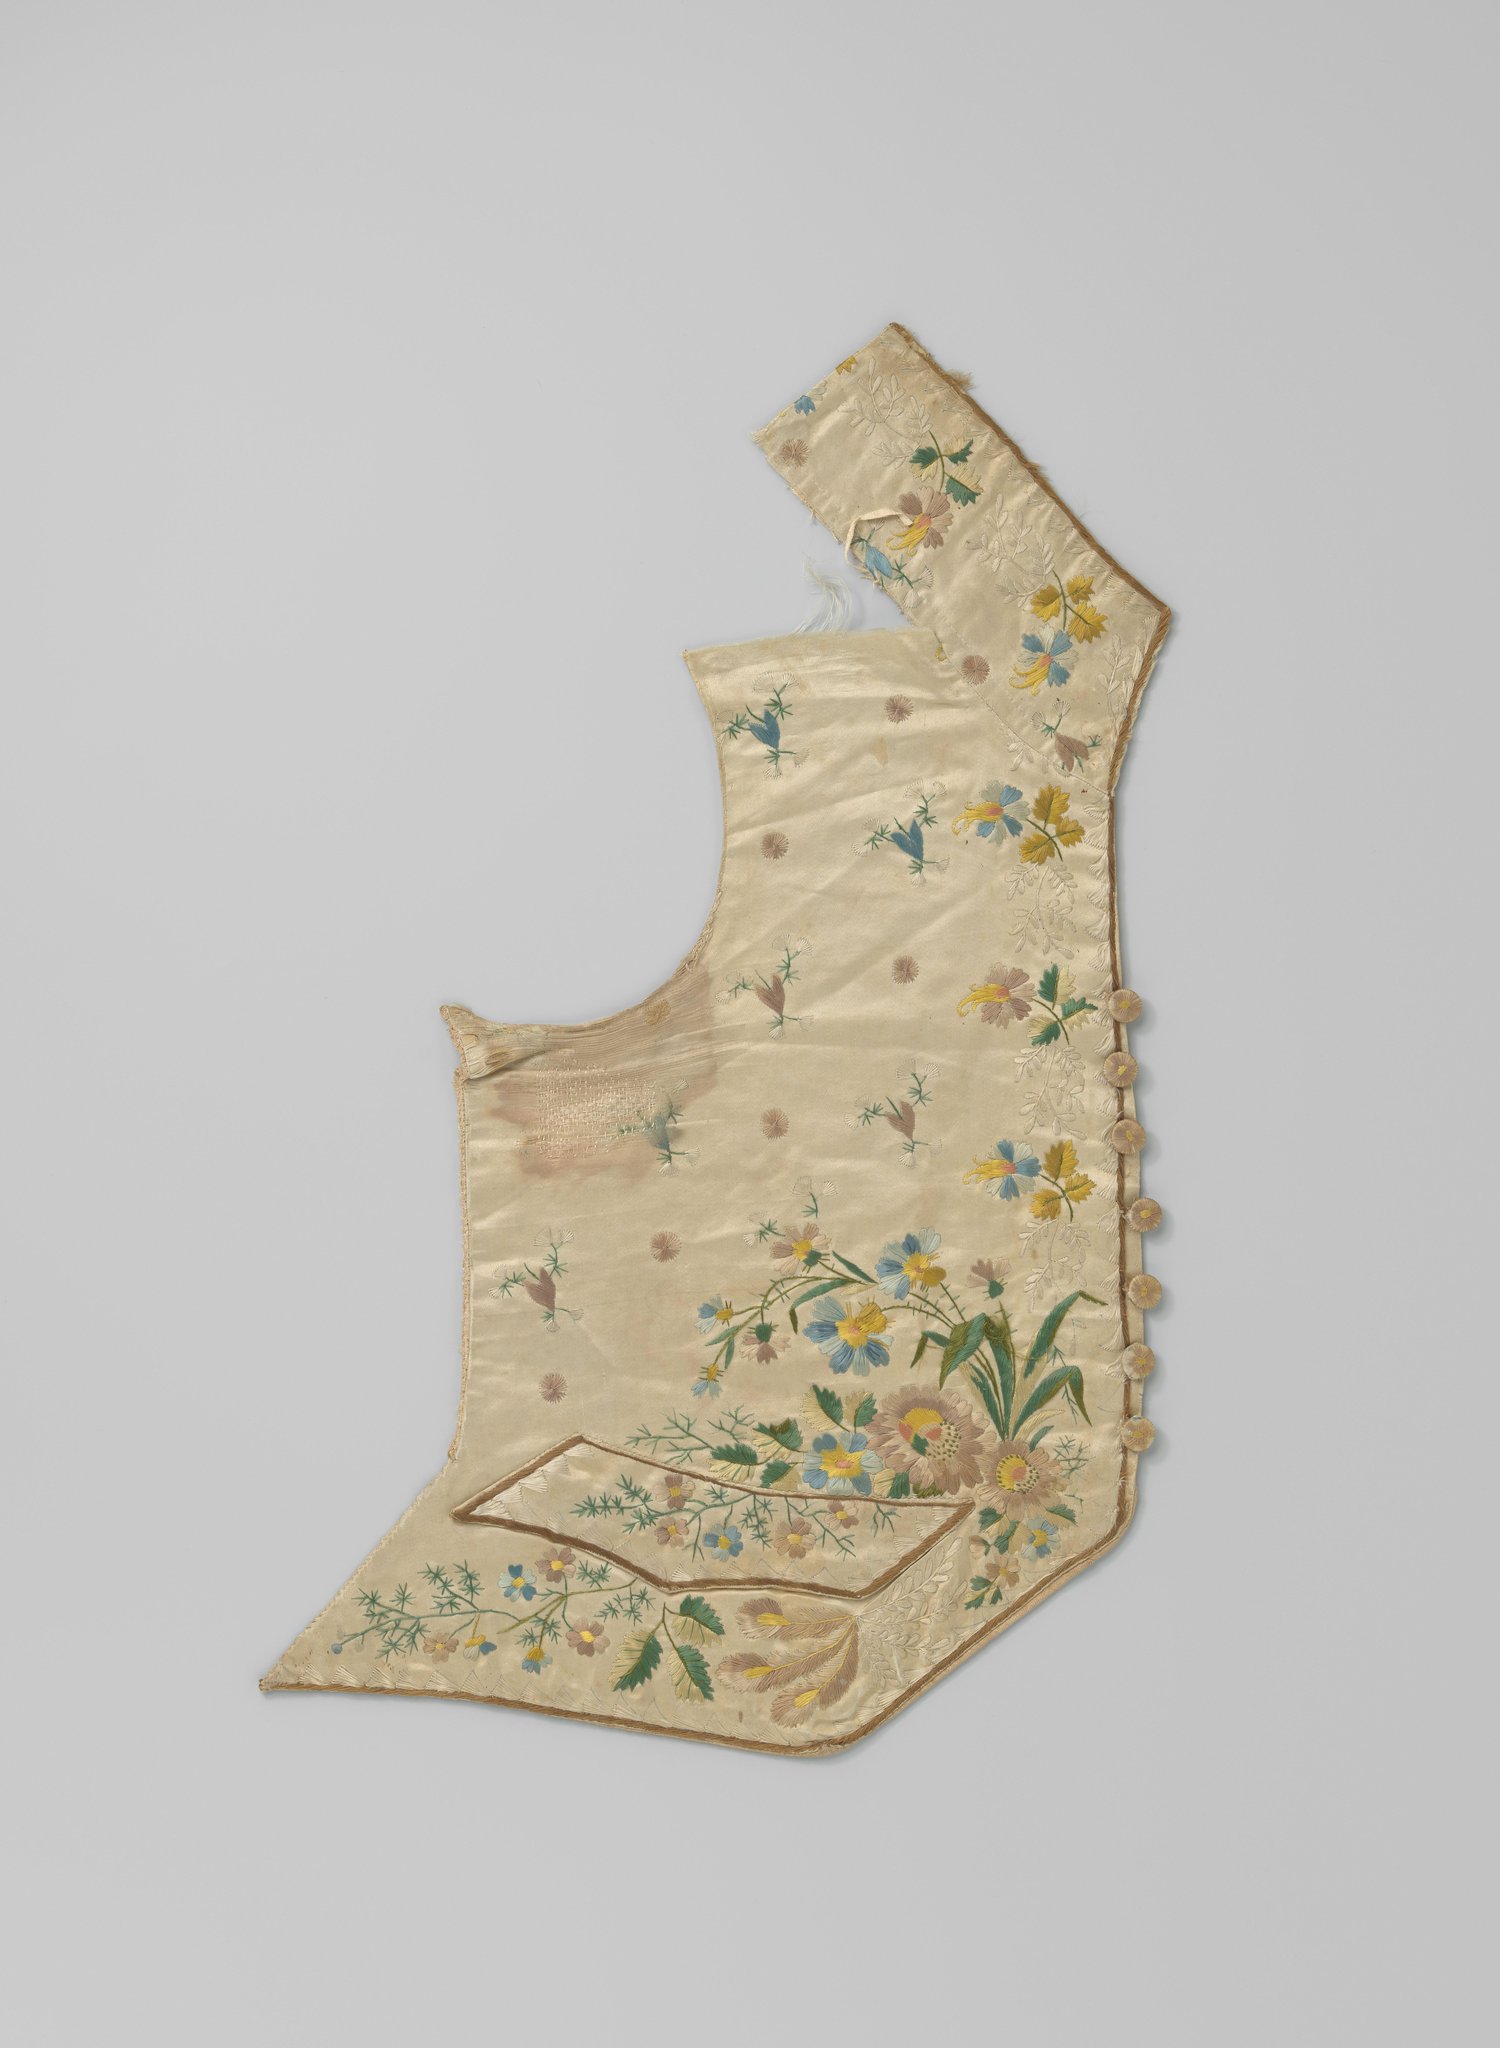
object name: vest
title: Vest, half, van wit satijn met geborduurde zijden bloemen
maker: Anonymous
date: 1750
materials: textile, silk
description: Vest, half, van wit satijn met geborduurde zijden bloemen. Nederland.